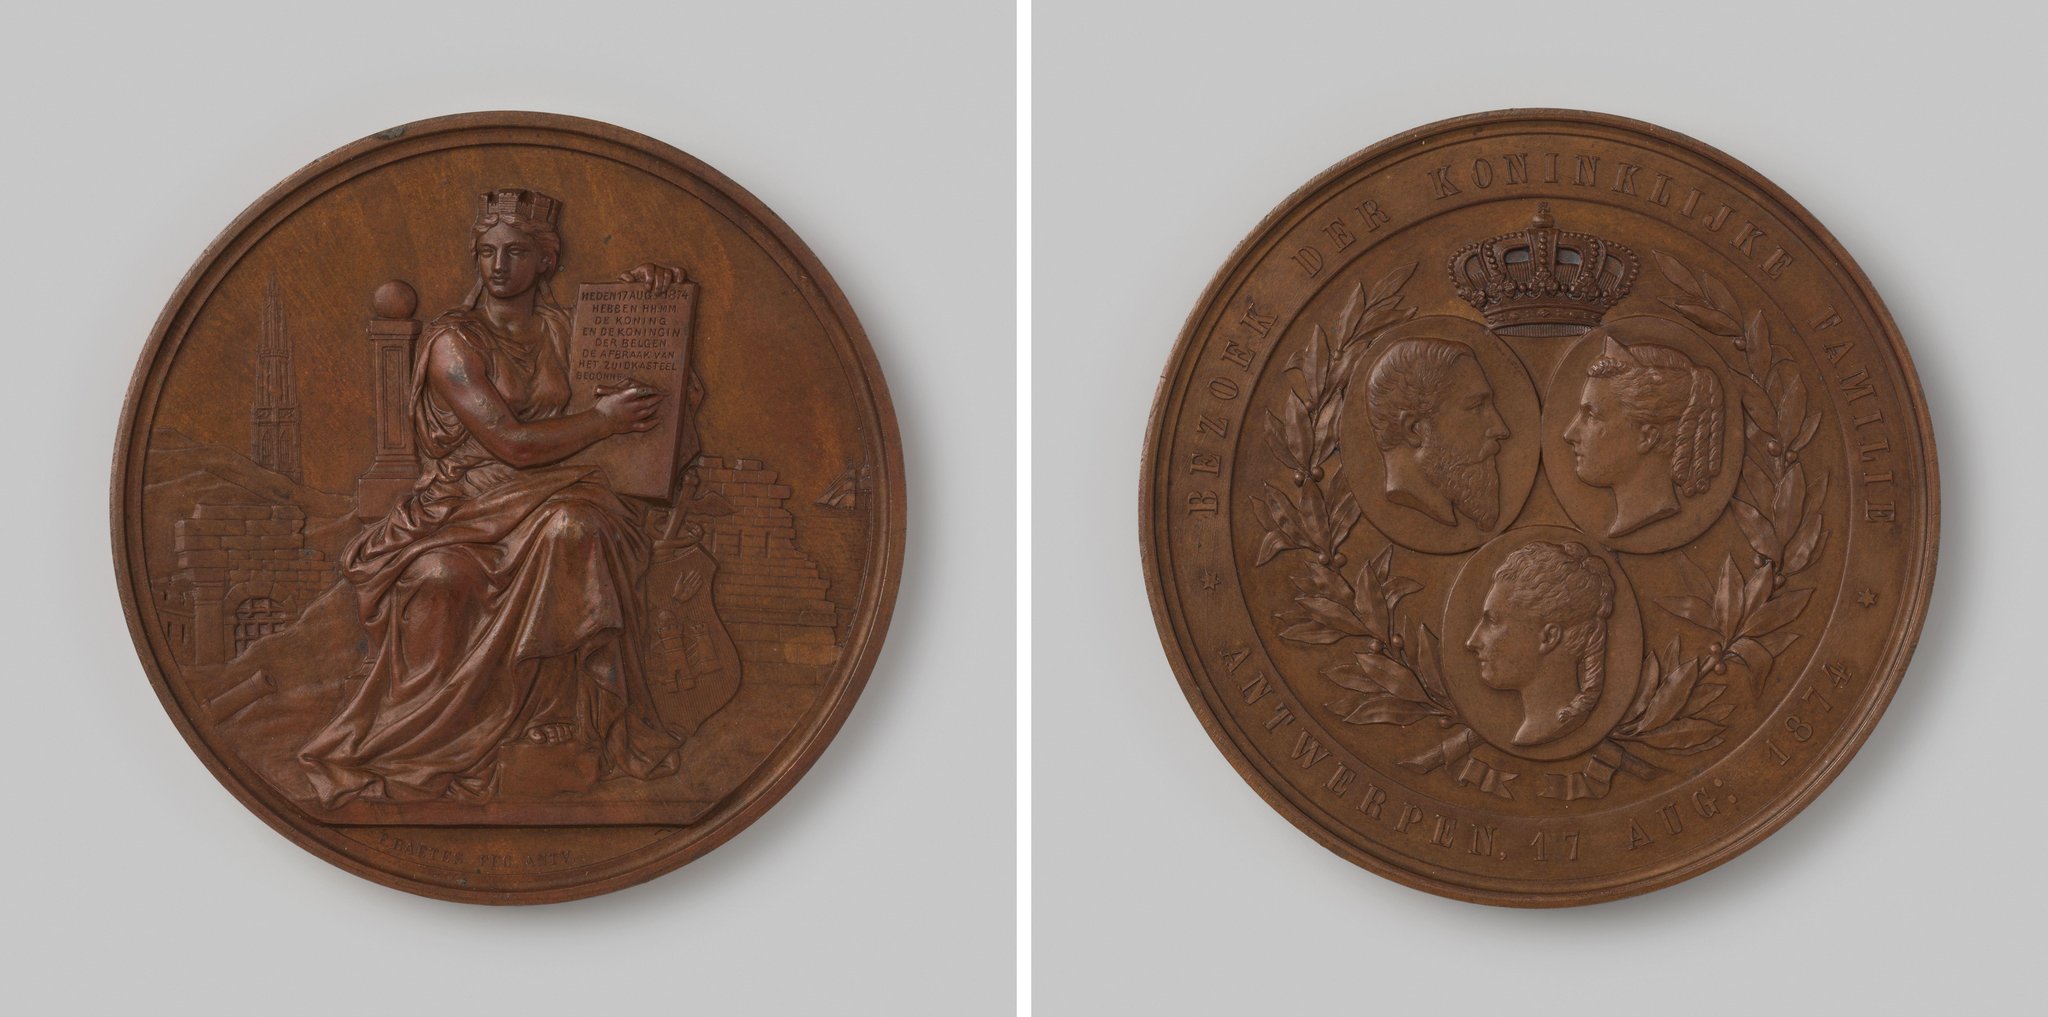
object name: history medal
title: Bezoek van de Belgische koninklijke familie aan Antwerpen 1874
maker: francois ignace baetes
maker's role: sculptor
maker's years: 1826-1890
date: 1874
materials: bronze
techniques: striking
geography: antwerp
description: Bronzen penning, op de voorzijdeeen tronende stadsgodin schrijvend op een tablet te midden van de ruines van het Antwerps kasteel, op de keerzijde drie ovalen medaillons met de portretten van de koninklijke familie onder een kroon en tussen lauwertakken, met omschrift.